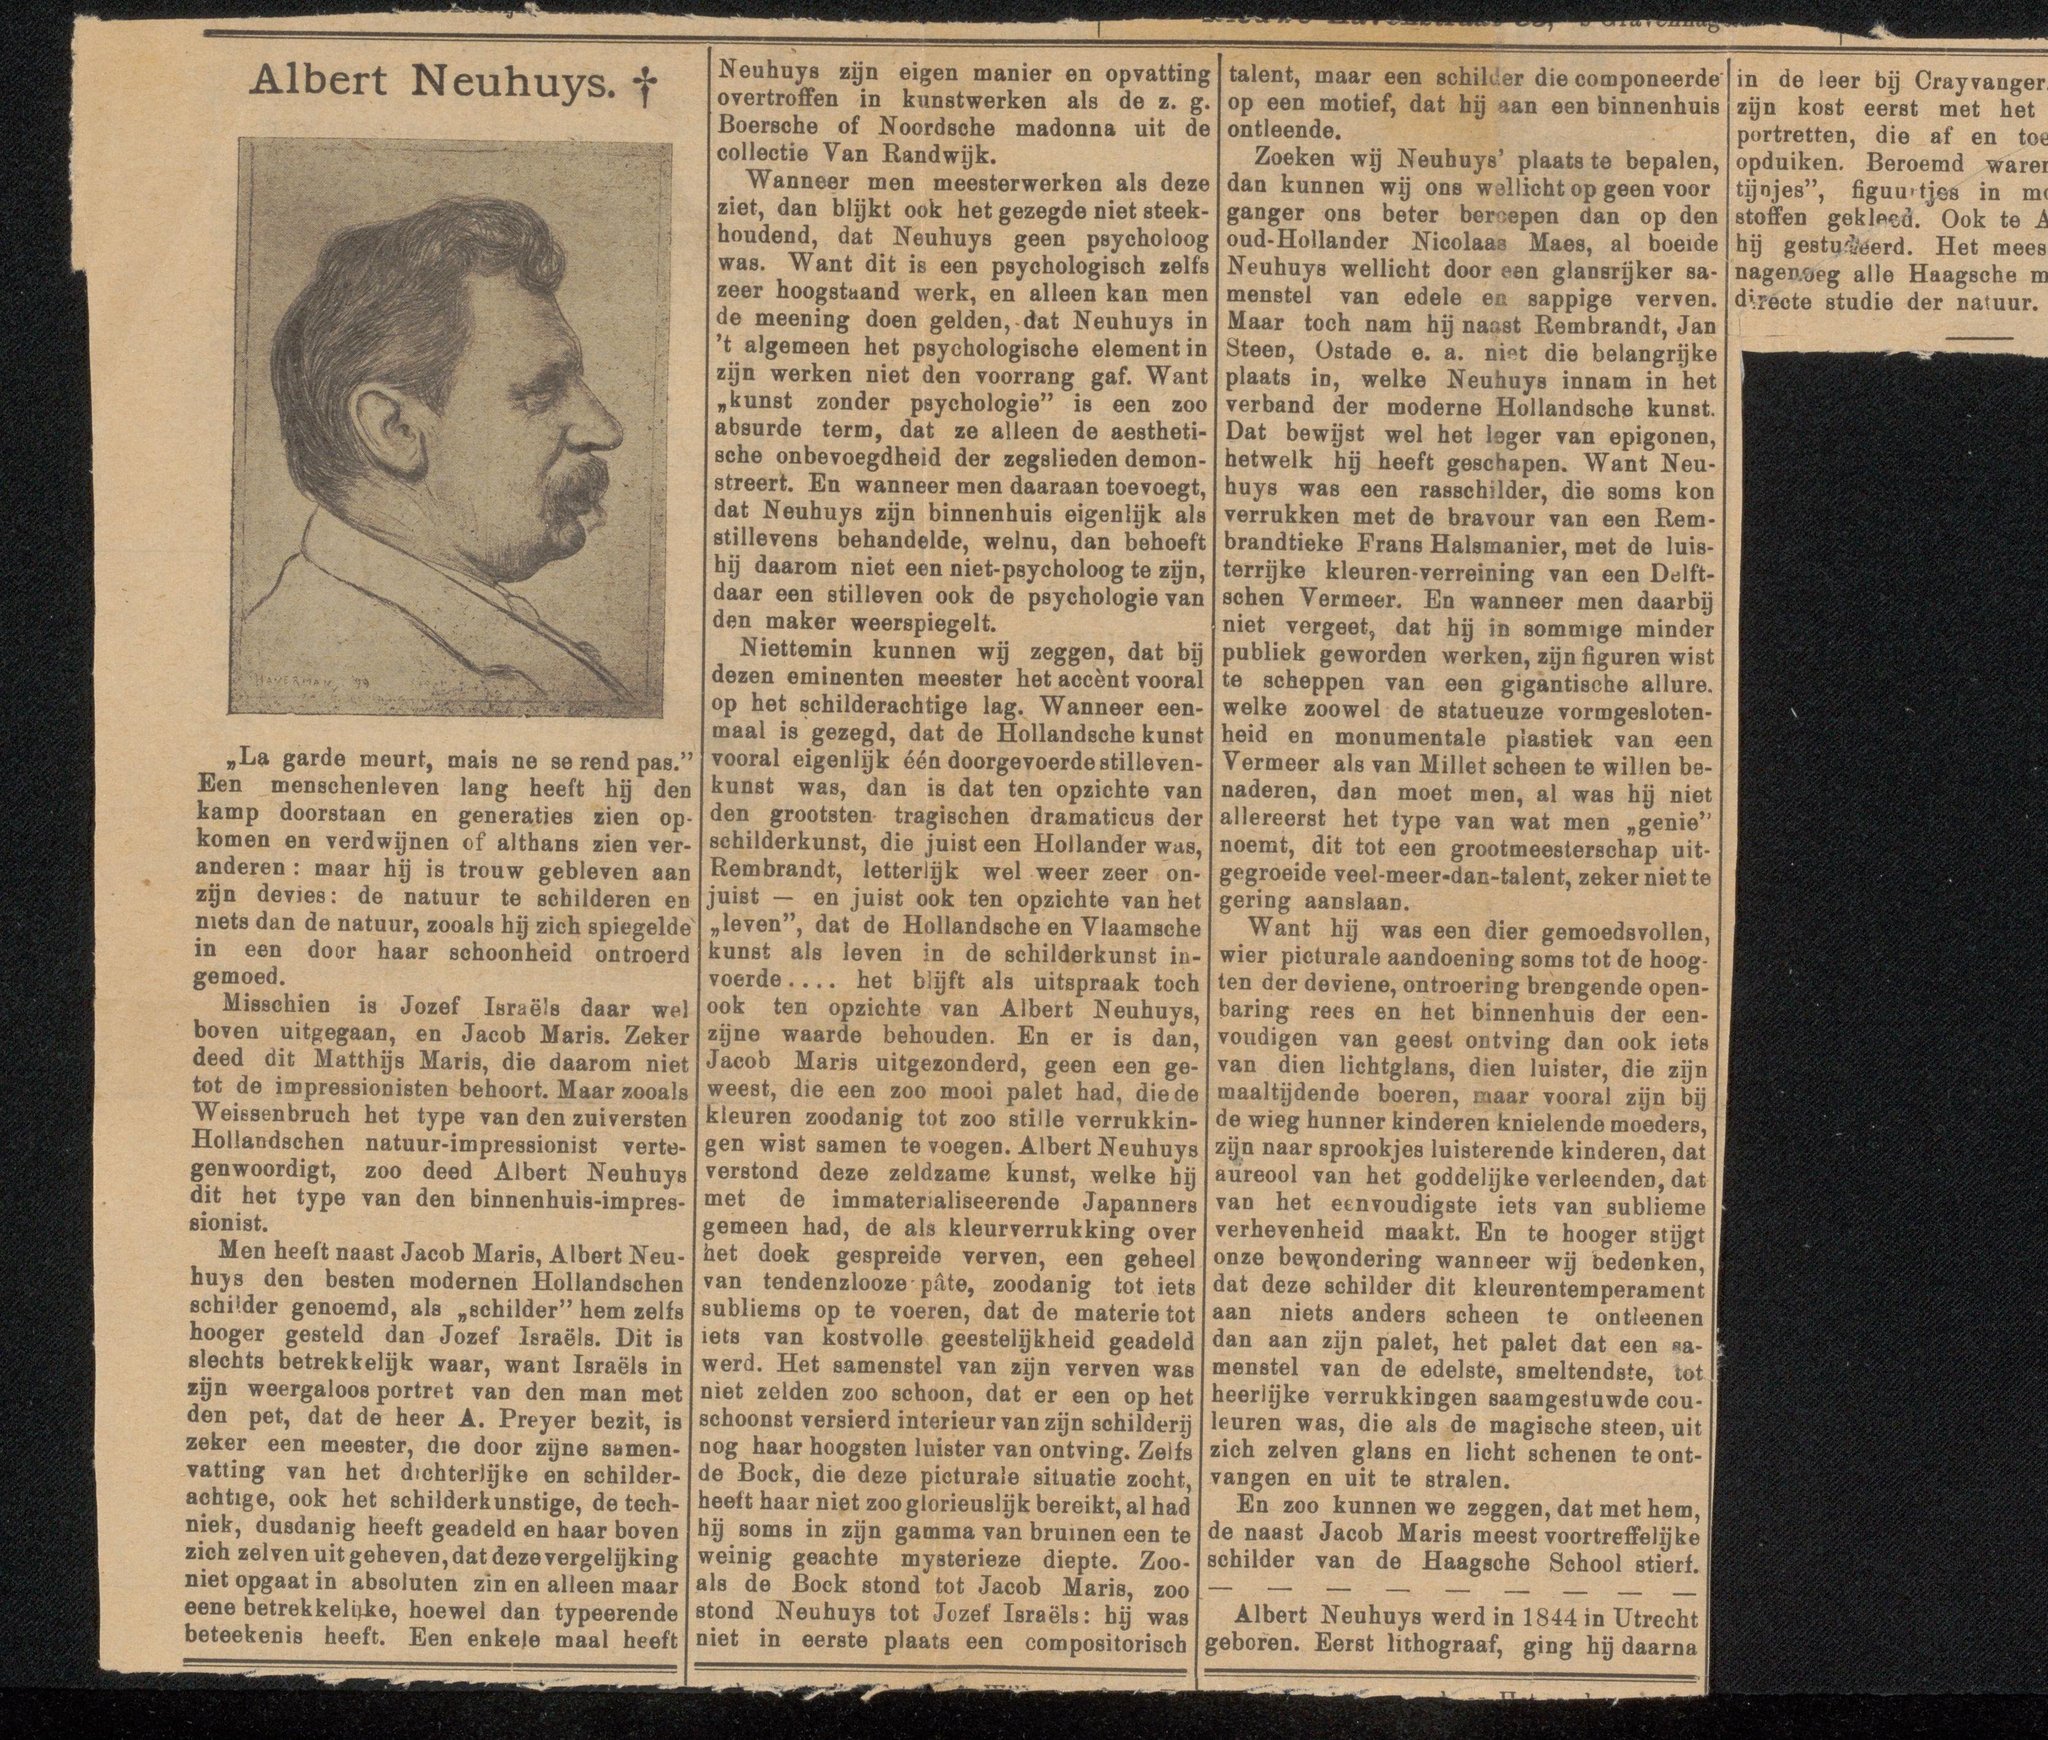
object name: newspaper clipping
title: Krantenknipsel uit archief Philip Zilcken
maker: Anonymous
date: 1914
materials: paper, ink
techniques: printing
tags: utrecht, print maker, albert neuhuys (1844-1914), the hague, painter, draughtsman, philip zilcken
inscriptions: collector's mark: ‘RPK’